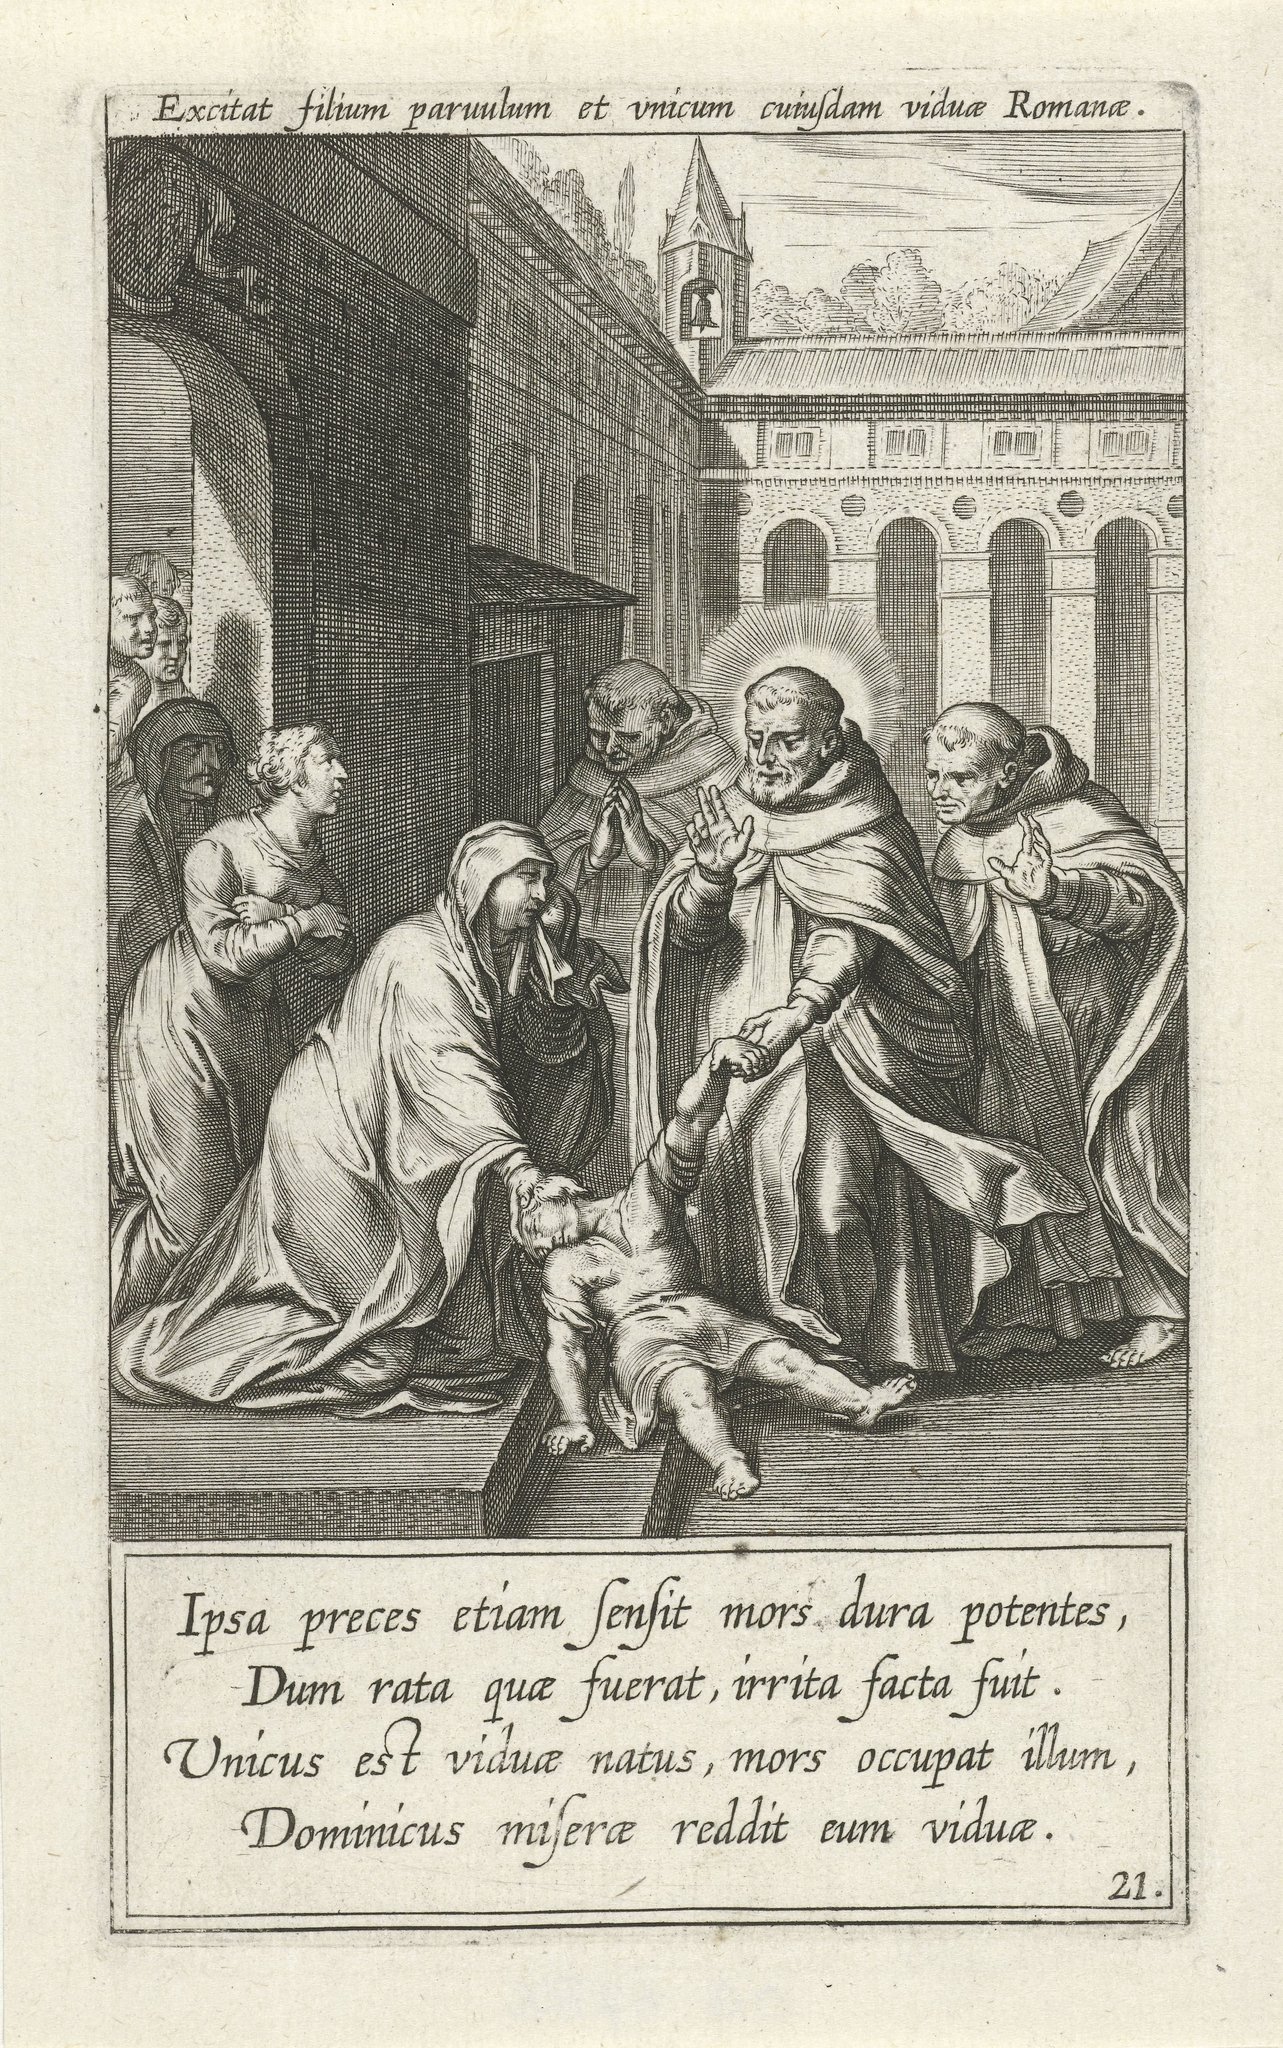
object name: book illustration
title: Opwekking van een dood kind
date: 1611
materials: paper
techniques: engraving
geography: antwerp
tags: miraculous activities and events ~ st. dominic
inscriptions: collector's mark: Lugt 2228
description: Een vrouw smeekt de heilige Dominicus haar kind terug te halen uit de dood. De heilige Dominicus neemt de hand van het dode kind en wekt hem terug tot leven. De prent heeft een Latijns opschrift en onderschrift en maakt deel uit van een prentserie voor een boek over het leven van de heilige Dominicus.